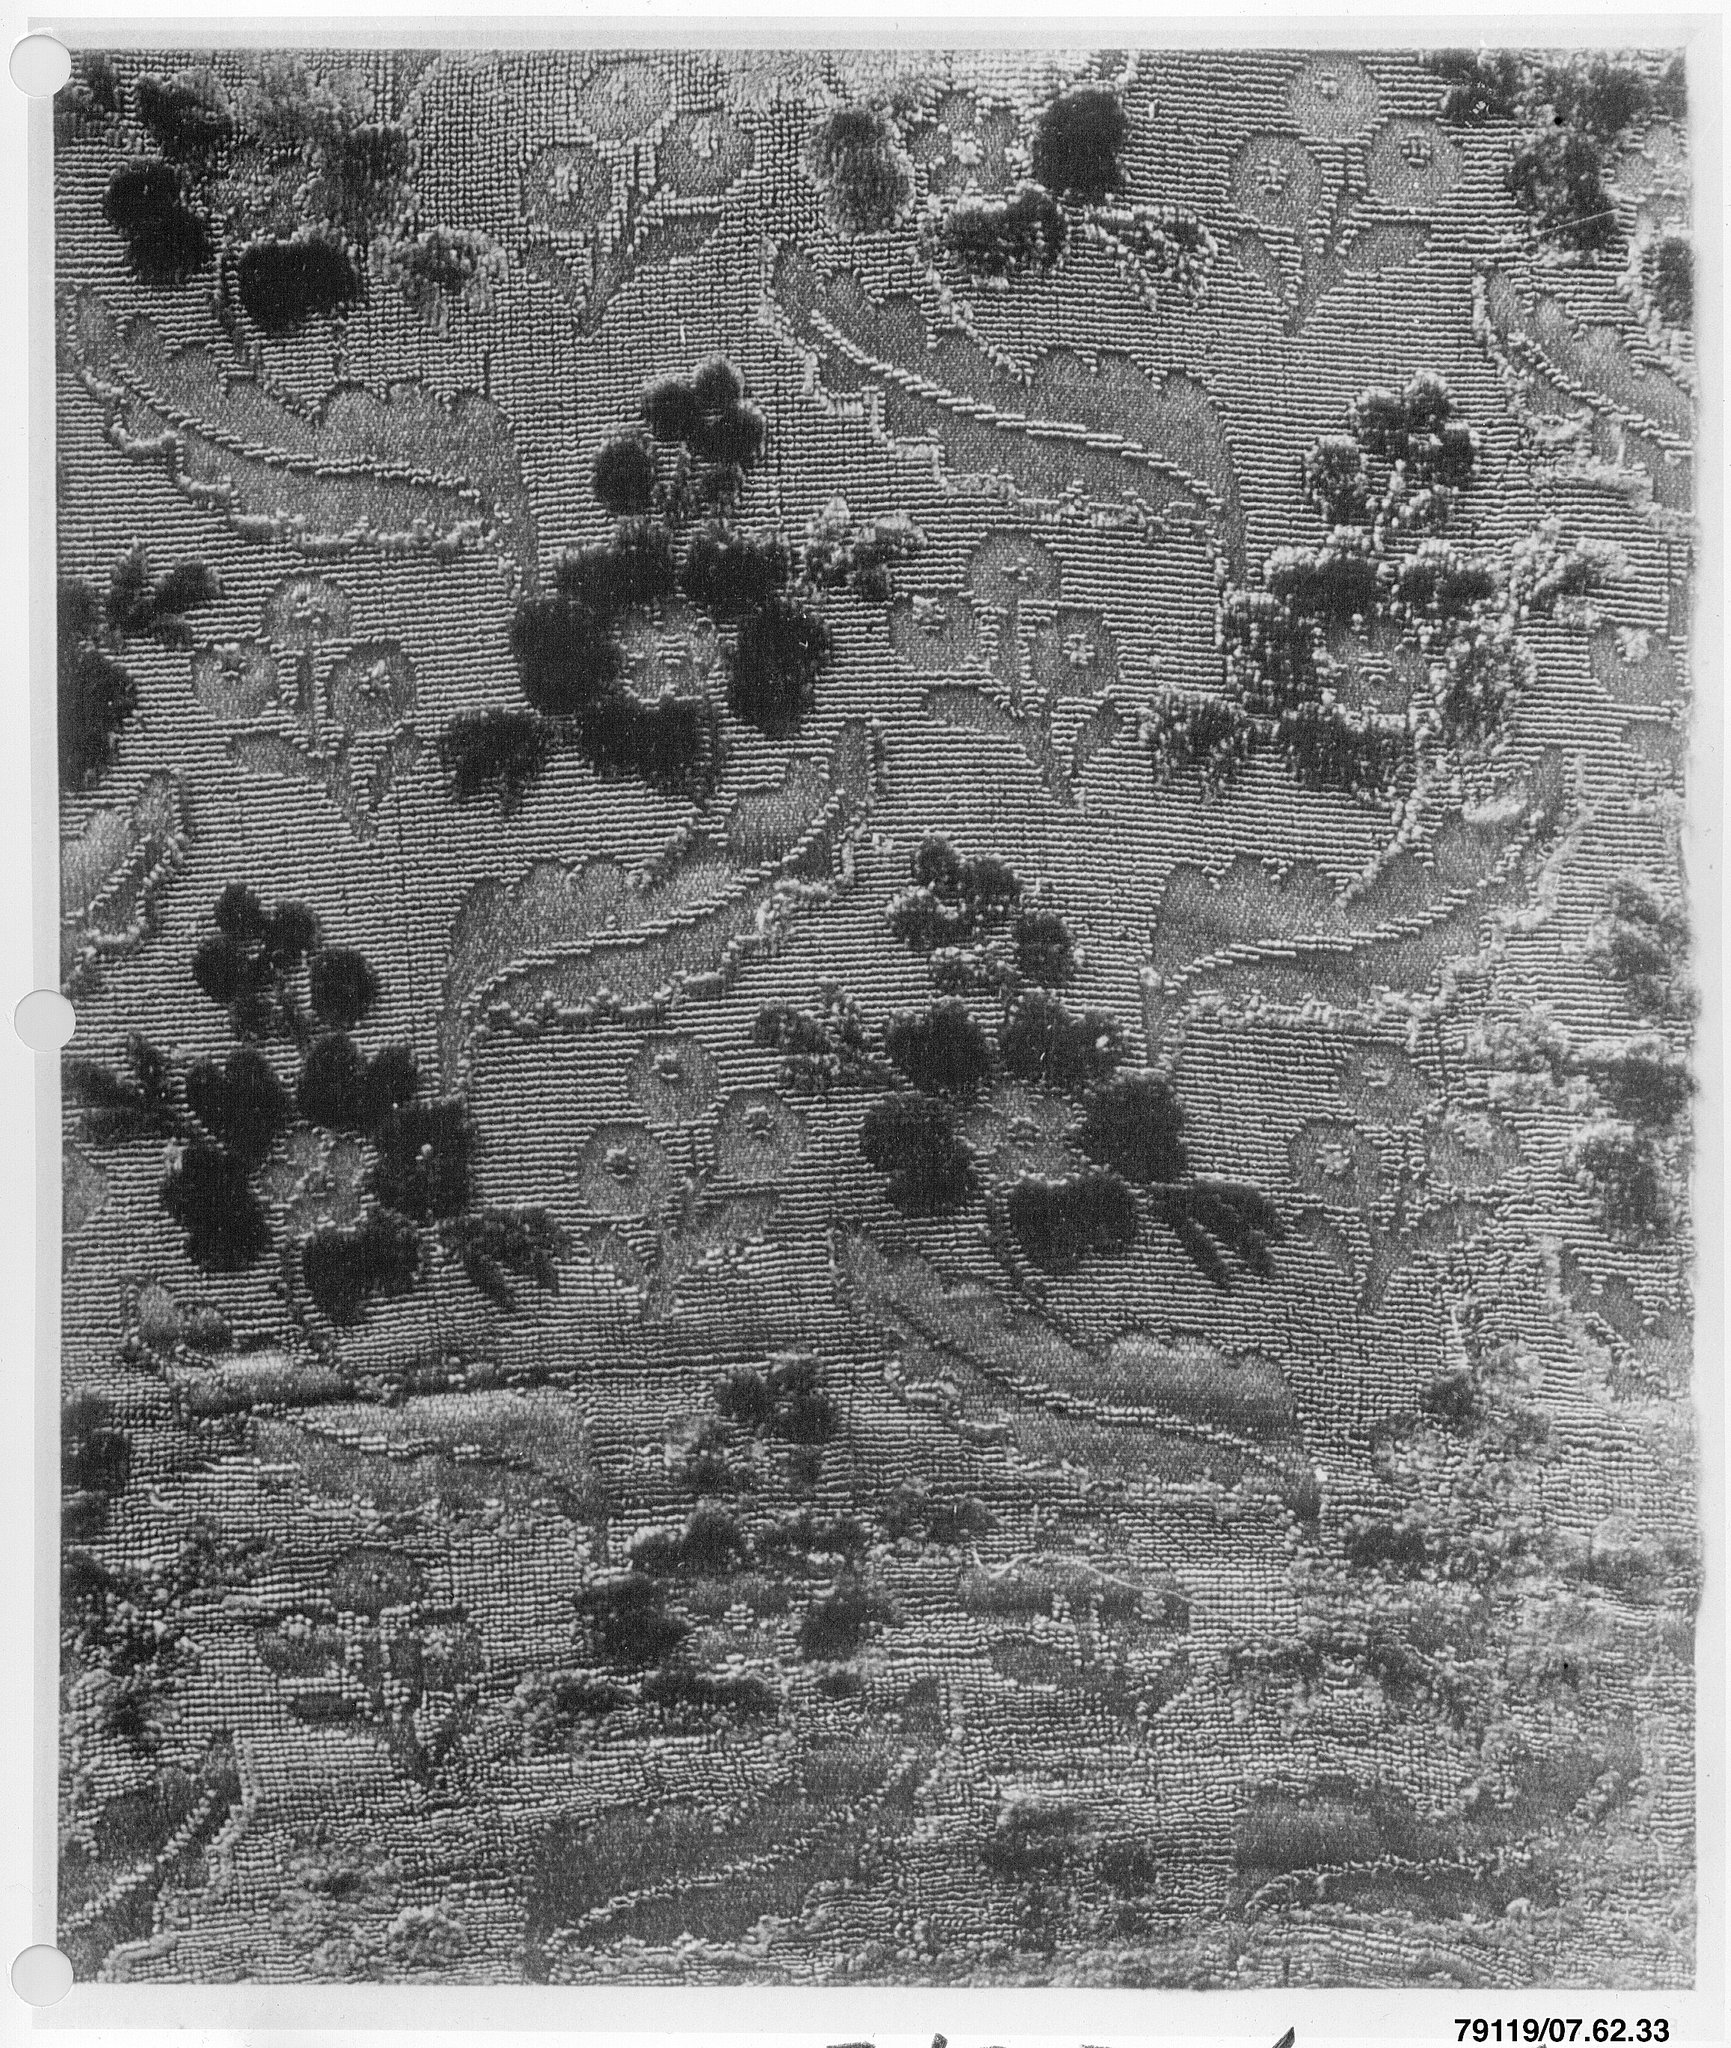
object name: piece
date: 1701-1800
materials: silk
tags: flowers,leaves